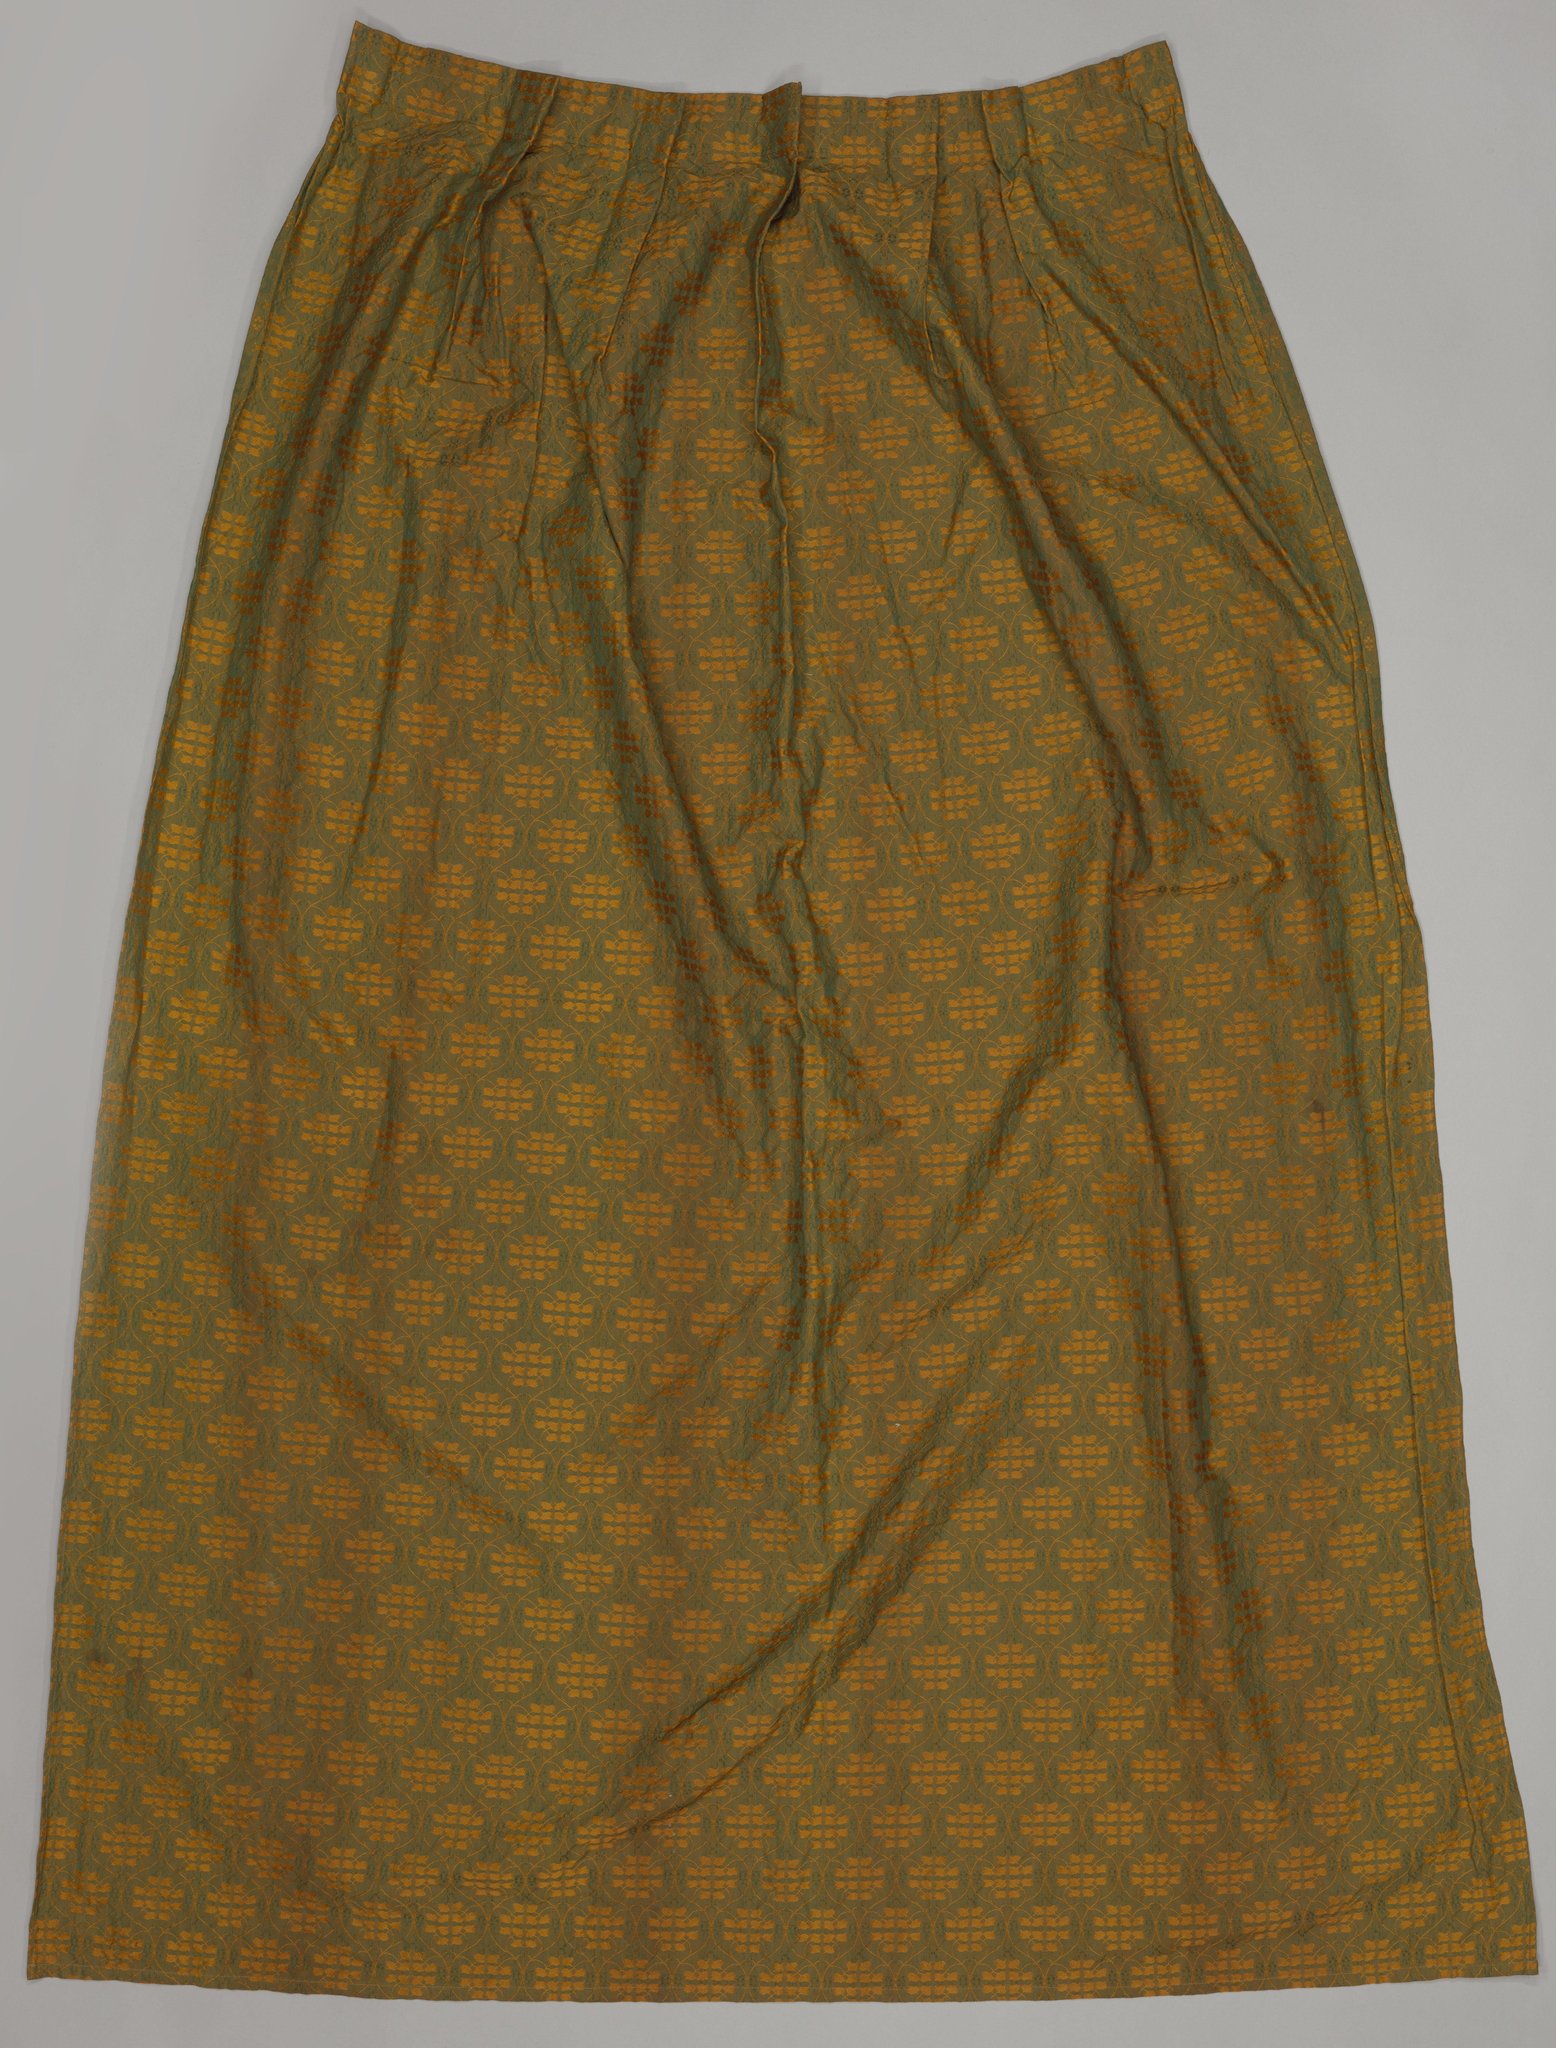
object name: curtain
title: Gordijn met patroon van bladeren binnen spitsovalen in geel op groene fond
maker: theo nieuwenhuis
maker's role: designer, draughtsman, print maker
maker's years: 1866-1951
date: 1904-1924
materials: cotton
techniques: jacquard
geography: helmond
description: Gordijn van jacquardweefsel met zich herhalend motief van bladeren binnen spitsovalen. Gele inslag op groene ketting. Voorzien van metalen ringen.